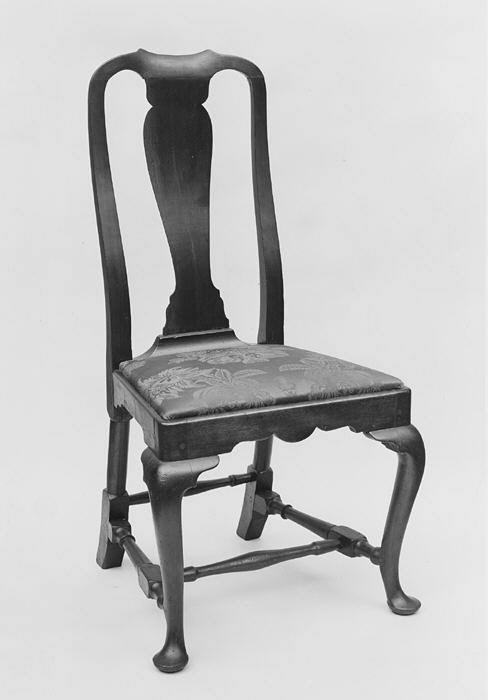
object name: side chair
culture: american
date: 1730-1760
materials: wood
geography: united states